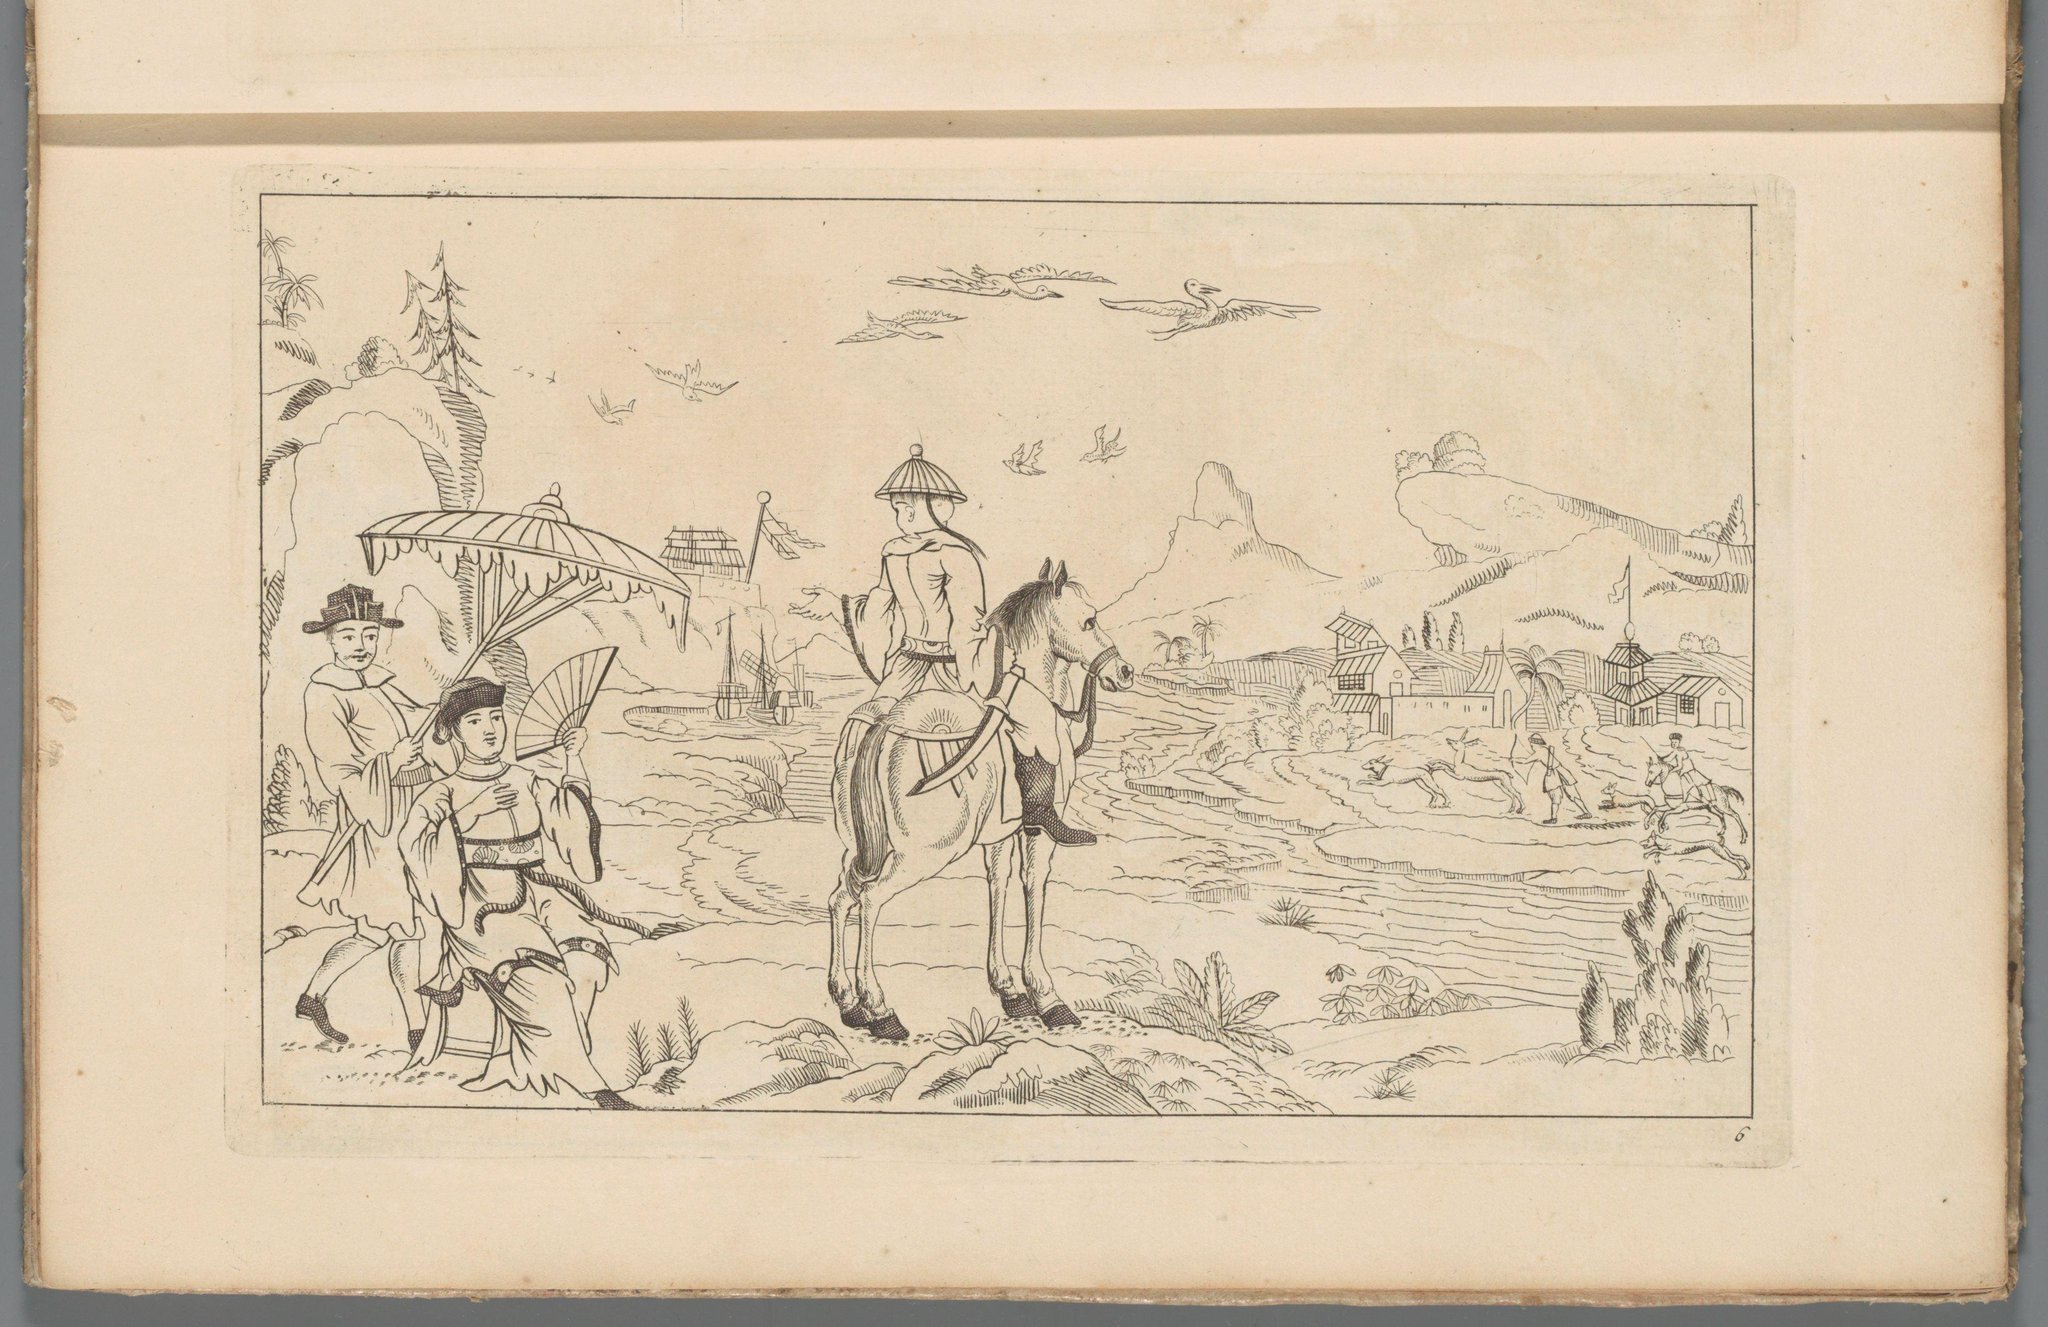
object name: ornament print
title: Chinese jachttaferelen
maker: pieter schenk (ii)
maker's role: draughtsman, print maker, publisher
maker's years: 1693-1775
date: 1727-1775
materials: paper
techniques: etching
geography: amsterdam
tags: chinese, river, hunt ~ mammals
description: Landschap met links een ruiter en een figuur met waaier onder een parasol. Door het landschap gaat een rivier met aan de overzijde een jachttafereel. Prent maakt deel uit van een album.